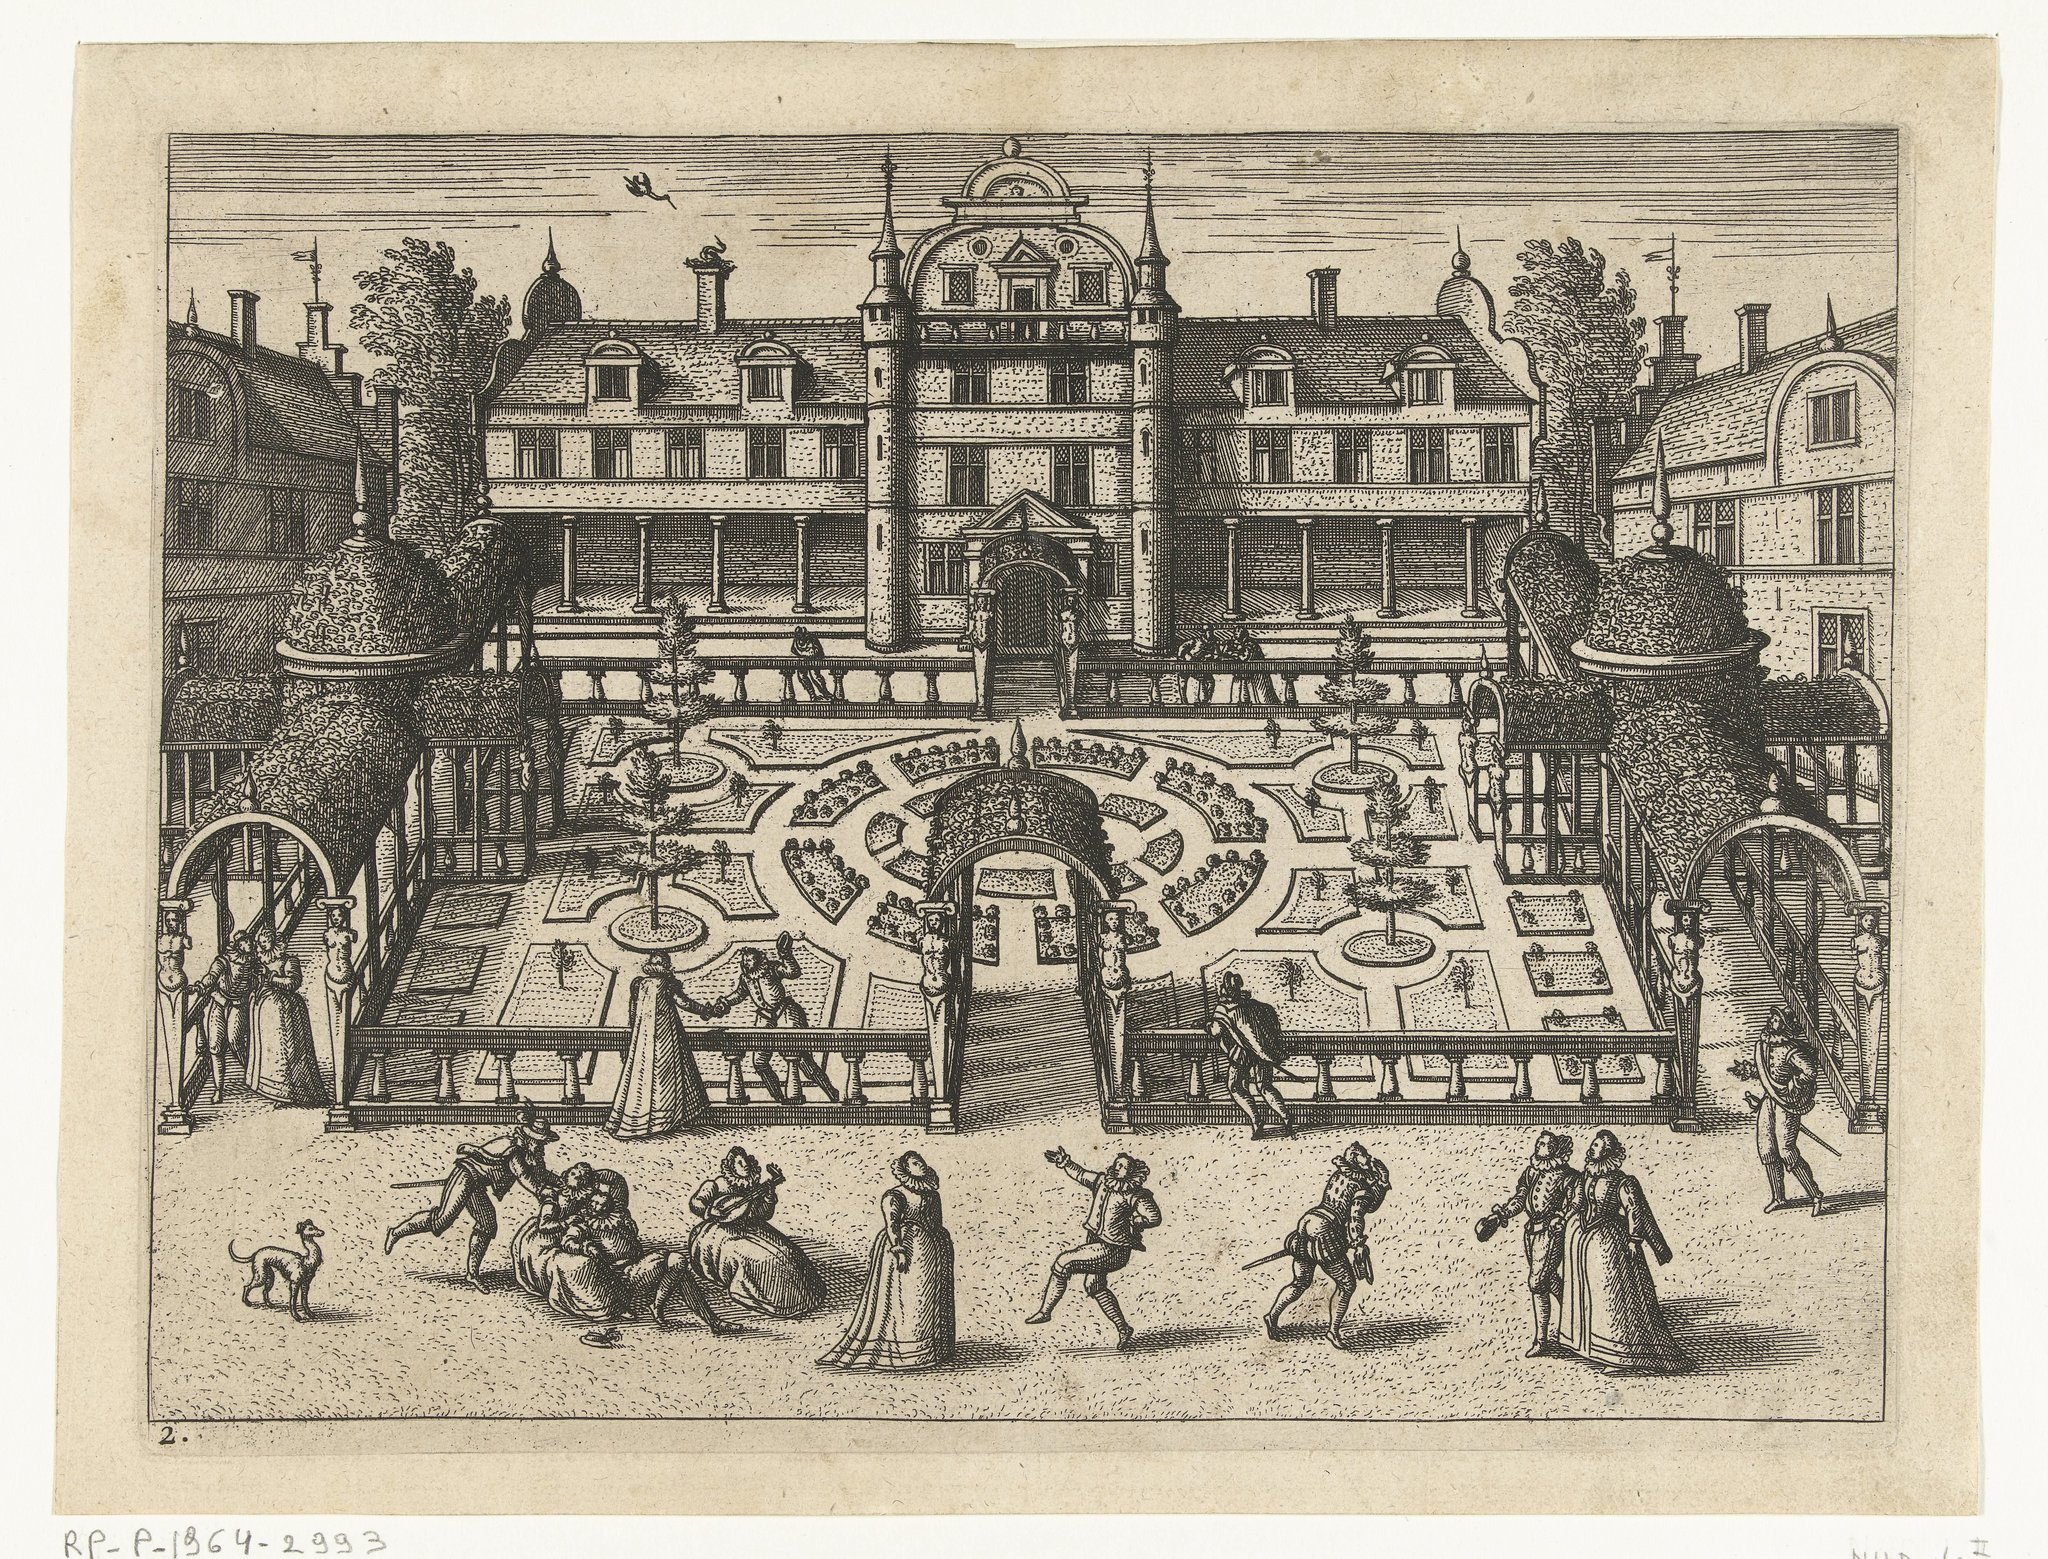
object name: print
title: Muziek en dans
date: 1545-1608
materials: paper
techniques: etching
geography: antwerp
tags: french or architectonic garden; formal garden, garden of love, court of love, 'fête galante', one person playing string instrument (plucked), one person dancing alone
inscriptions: collector's mark: Lugt 2228, collector's mark: Lugt 2760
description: Hoftuin met paren die samen wandelen en plezier maken. Op de voorgrond danst een man voor een vrouw, terwijl een andere dame de luit speelt. Een hond (symbool voor de liefde) kijkt toe. Ook andere paren bekijken en wijzen naar het schouwspel. De serie toont verschillende aspecten van hofmakerij en enkele voorbeelden uit het Oude Testament.